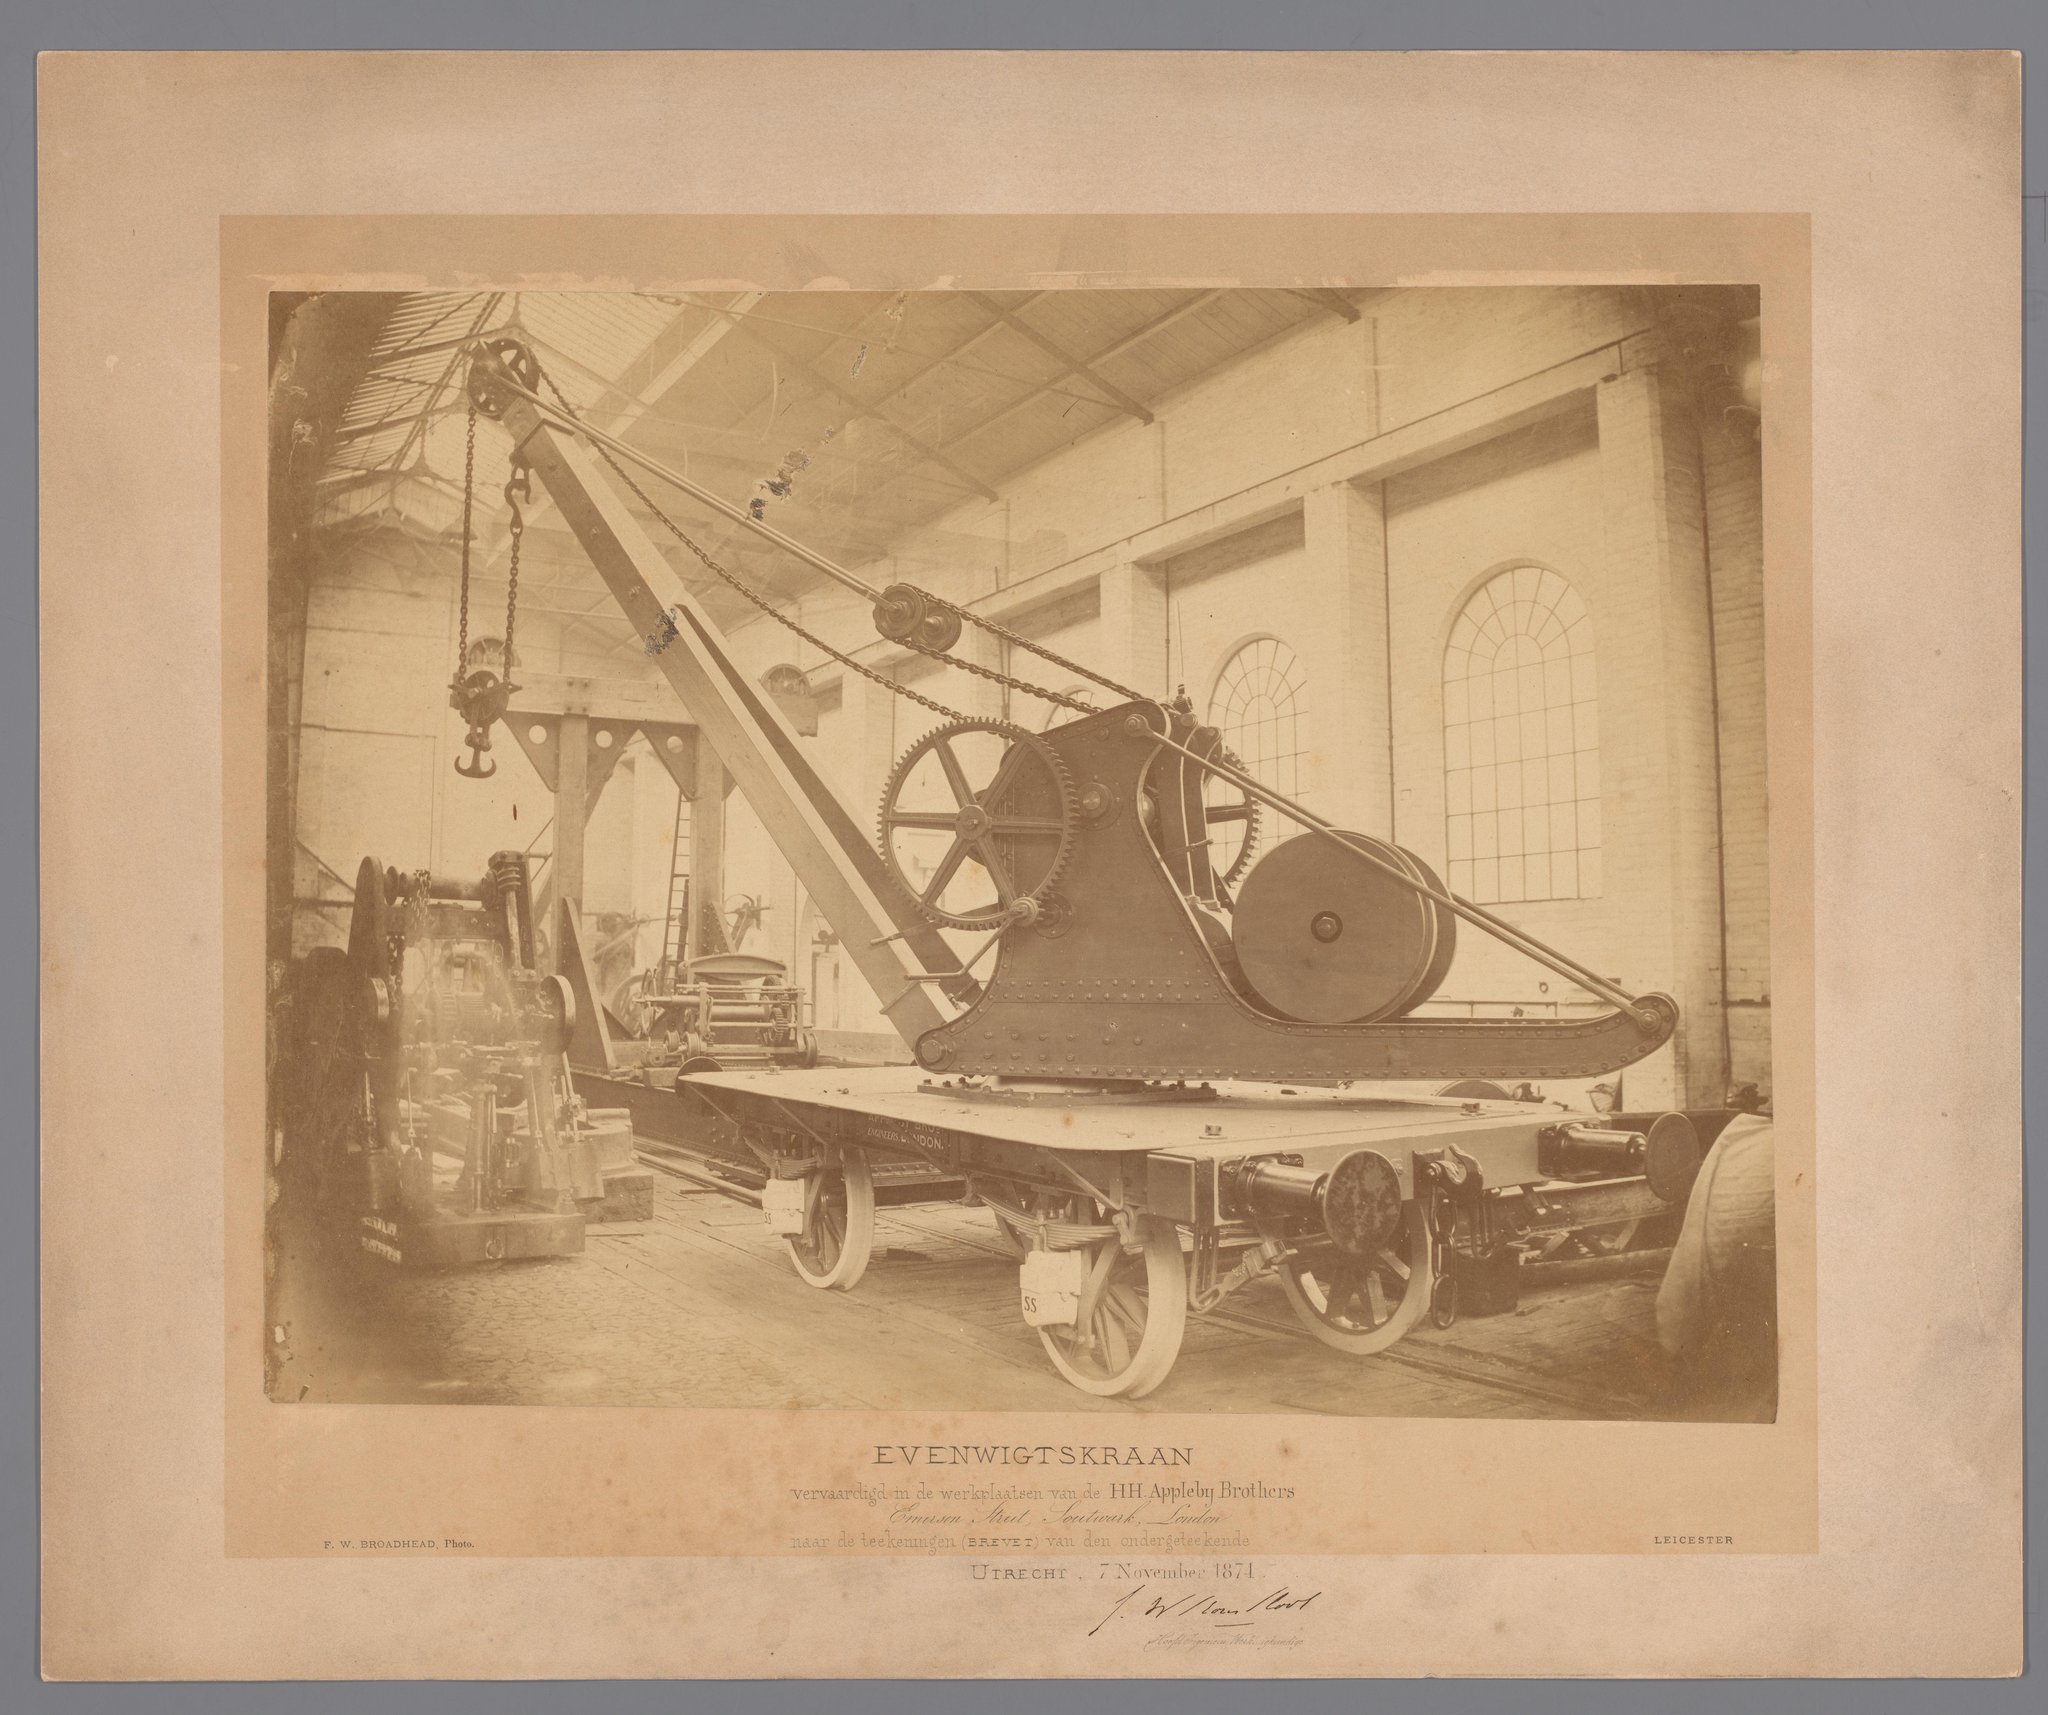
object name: photograph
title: "Evenwichtskraan", vervaardigd door HH. Appleby Brothers, Londen, Engeland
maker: frederick w. broadhead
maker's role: fotograaf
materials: cardboard, paper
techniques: albumen print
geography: leicester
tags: england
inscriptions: caption: ‘EVENWIGTSKRAAN//vervaardigd in de werkplaatsen van de HH. Appleby Brothers//Emerson Street Soutwark, londen//naar teekeningen (BREVET) van den ondergeteekende//Utrecht, 7 November 1874. J.W. Storn-Sloot [?]//Hoofd Ingenieur Werktuigkundige’, caption: ‘F.W. Broadhead, photo. LEICESTER’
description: "Evenwichtskraan", vervaardigd door HH. Appleby Brothers, Londen, Engeland, naar tekeningen van Hoofdingenieur Werktuigkundige J. W. Storn-Sloot [?], Utrecht, 7 november 1874